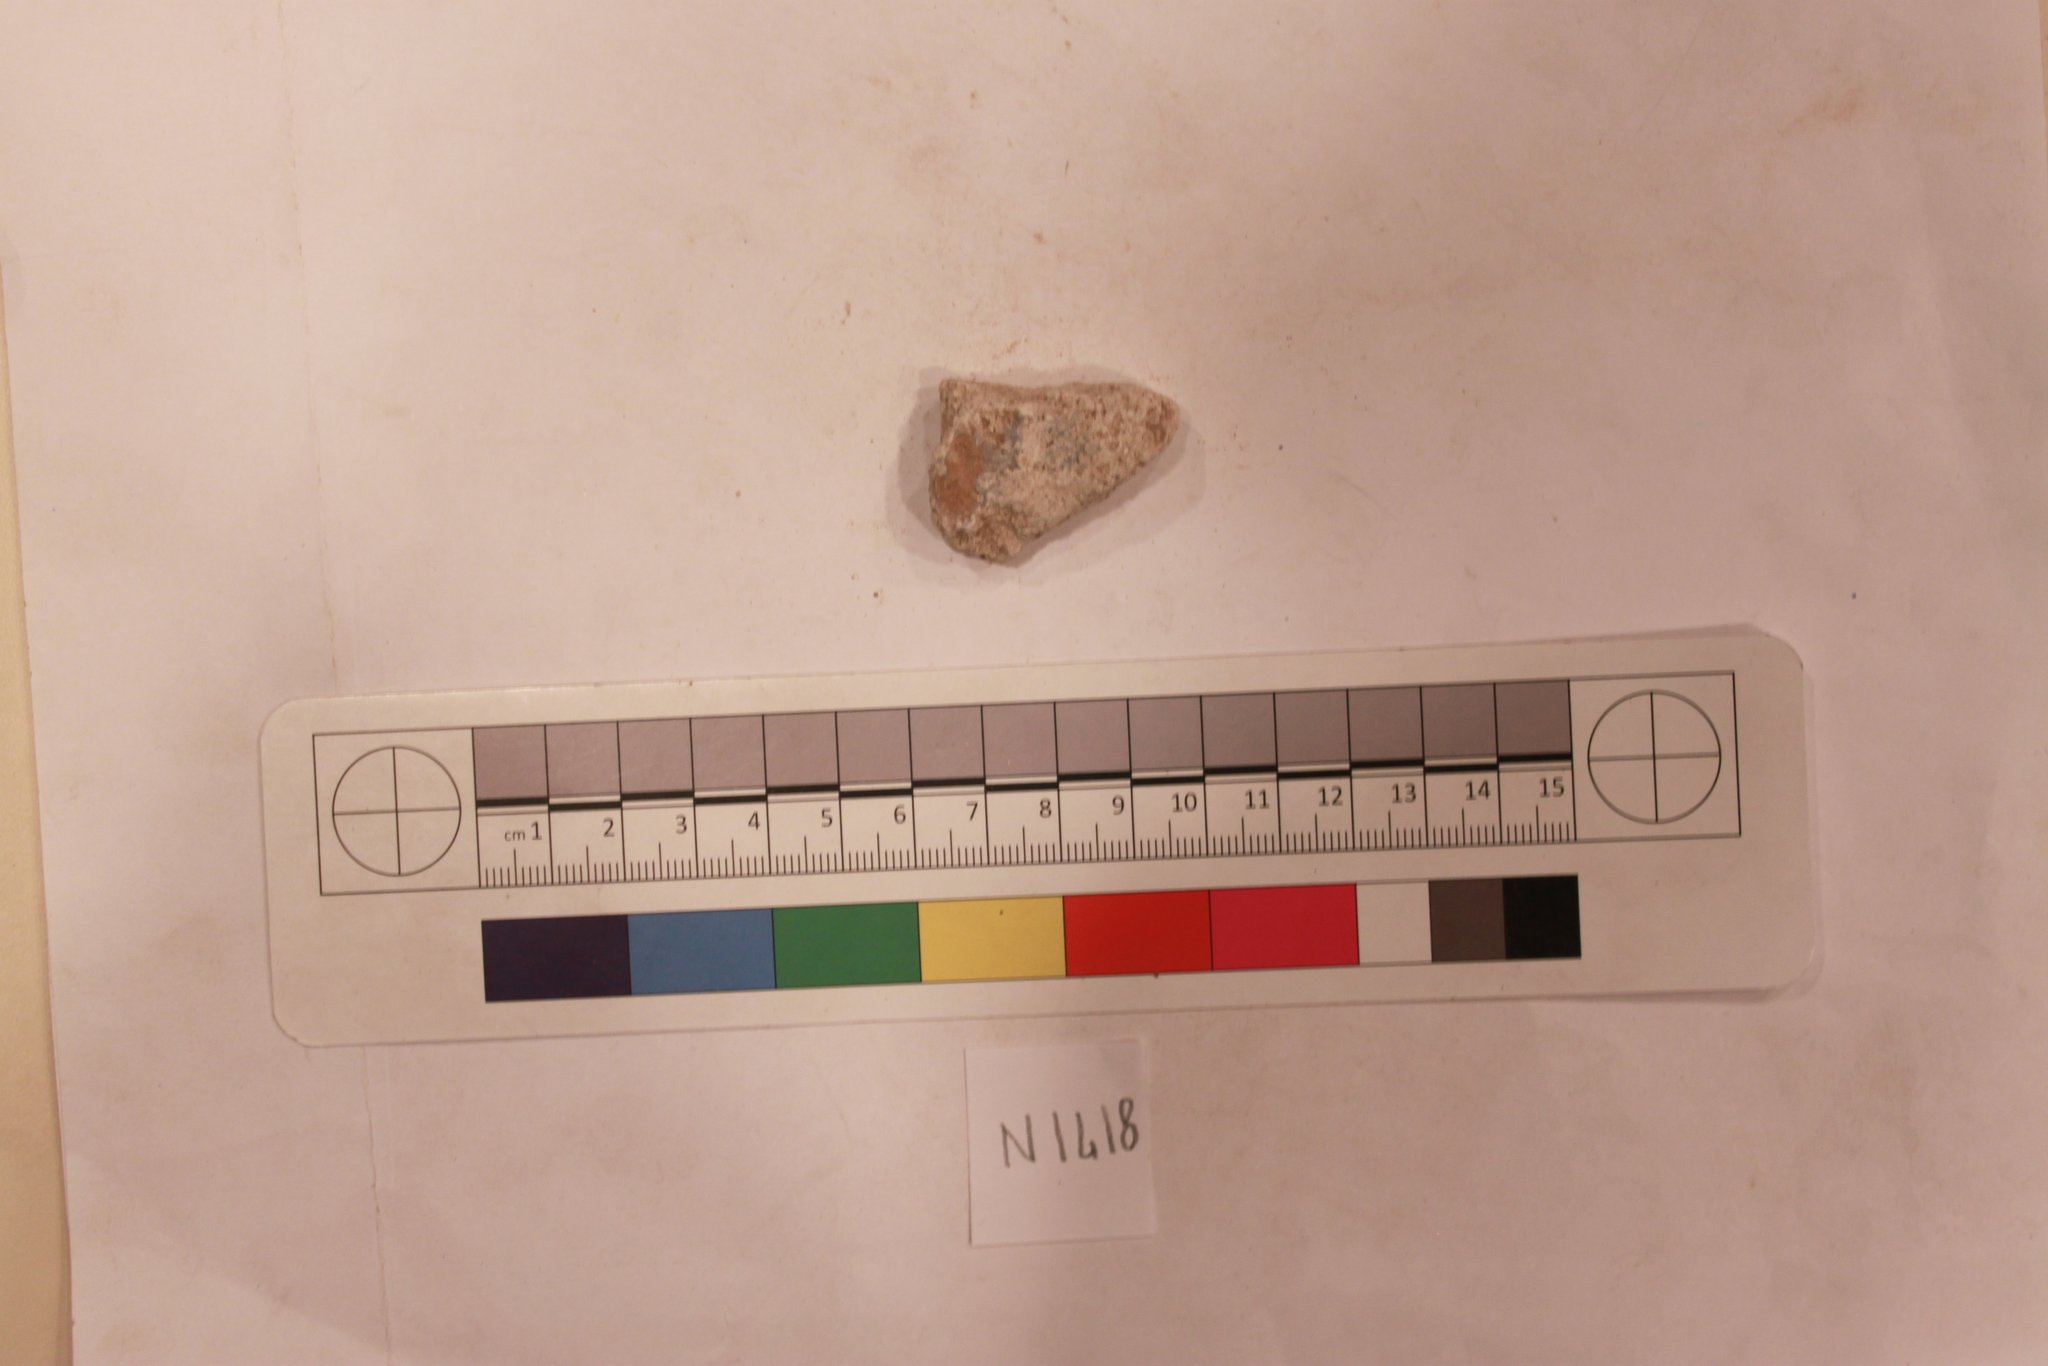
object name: fragment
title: Stucco Fragment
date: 701-1200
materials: plaster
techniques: carving, painting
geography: iran